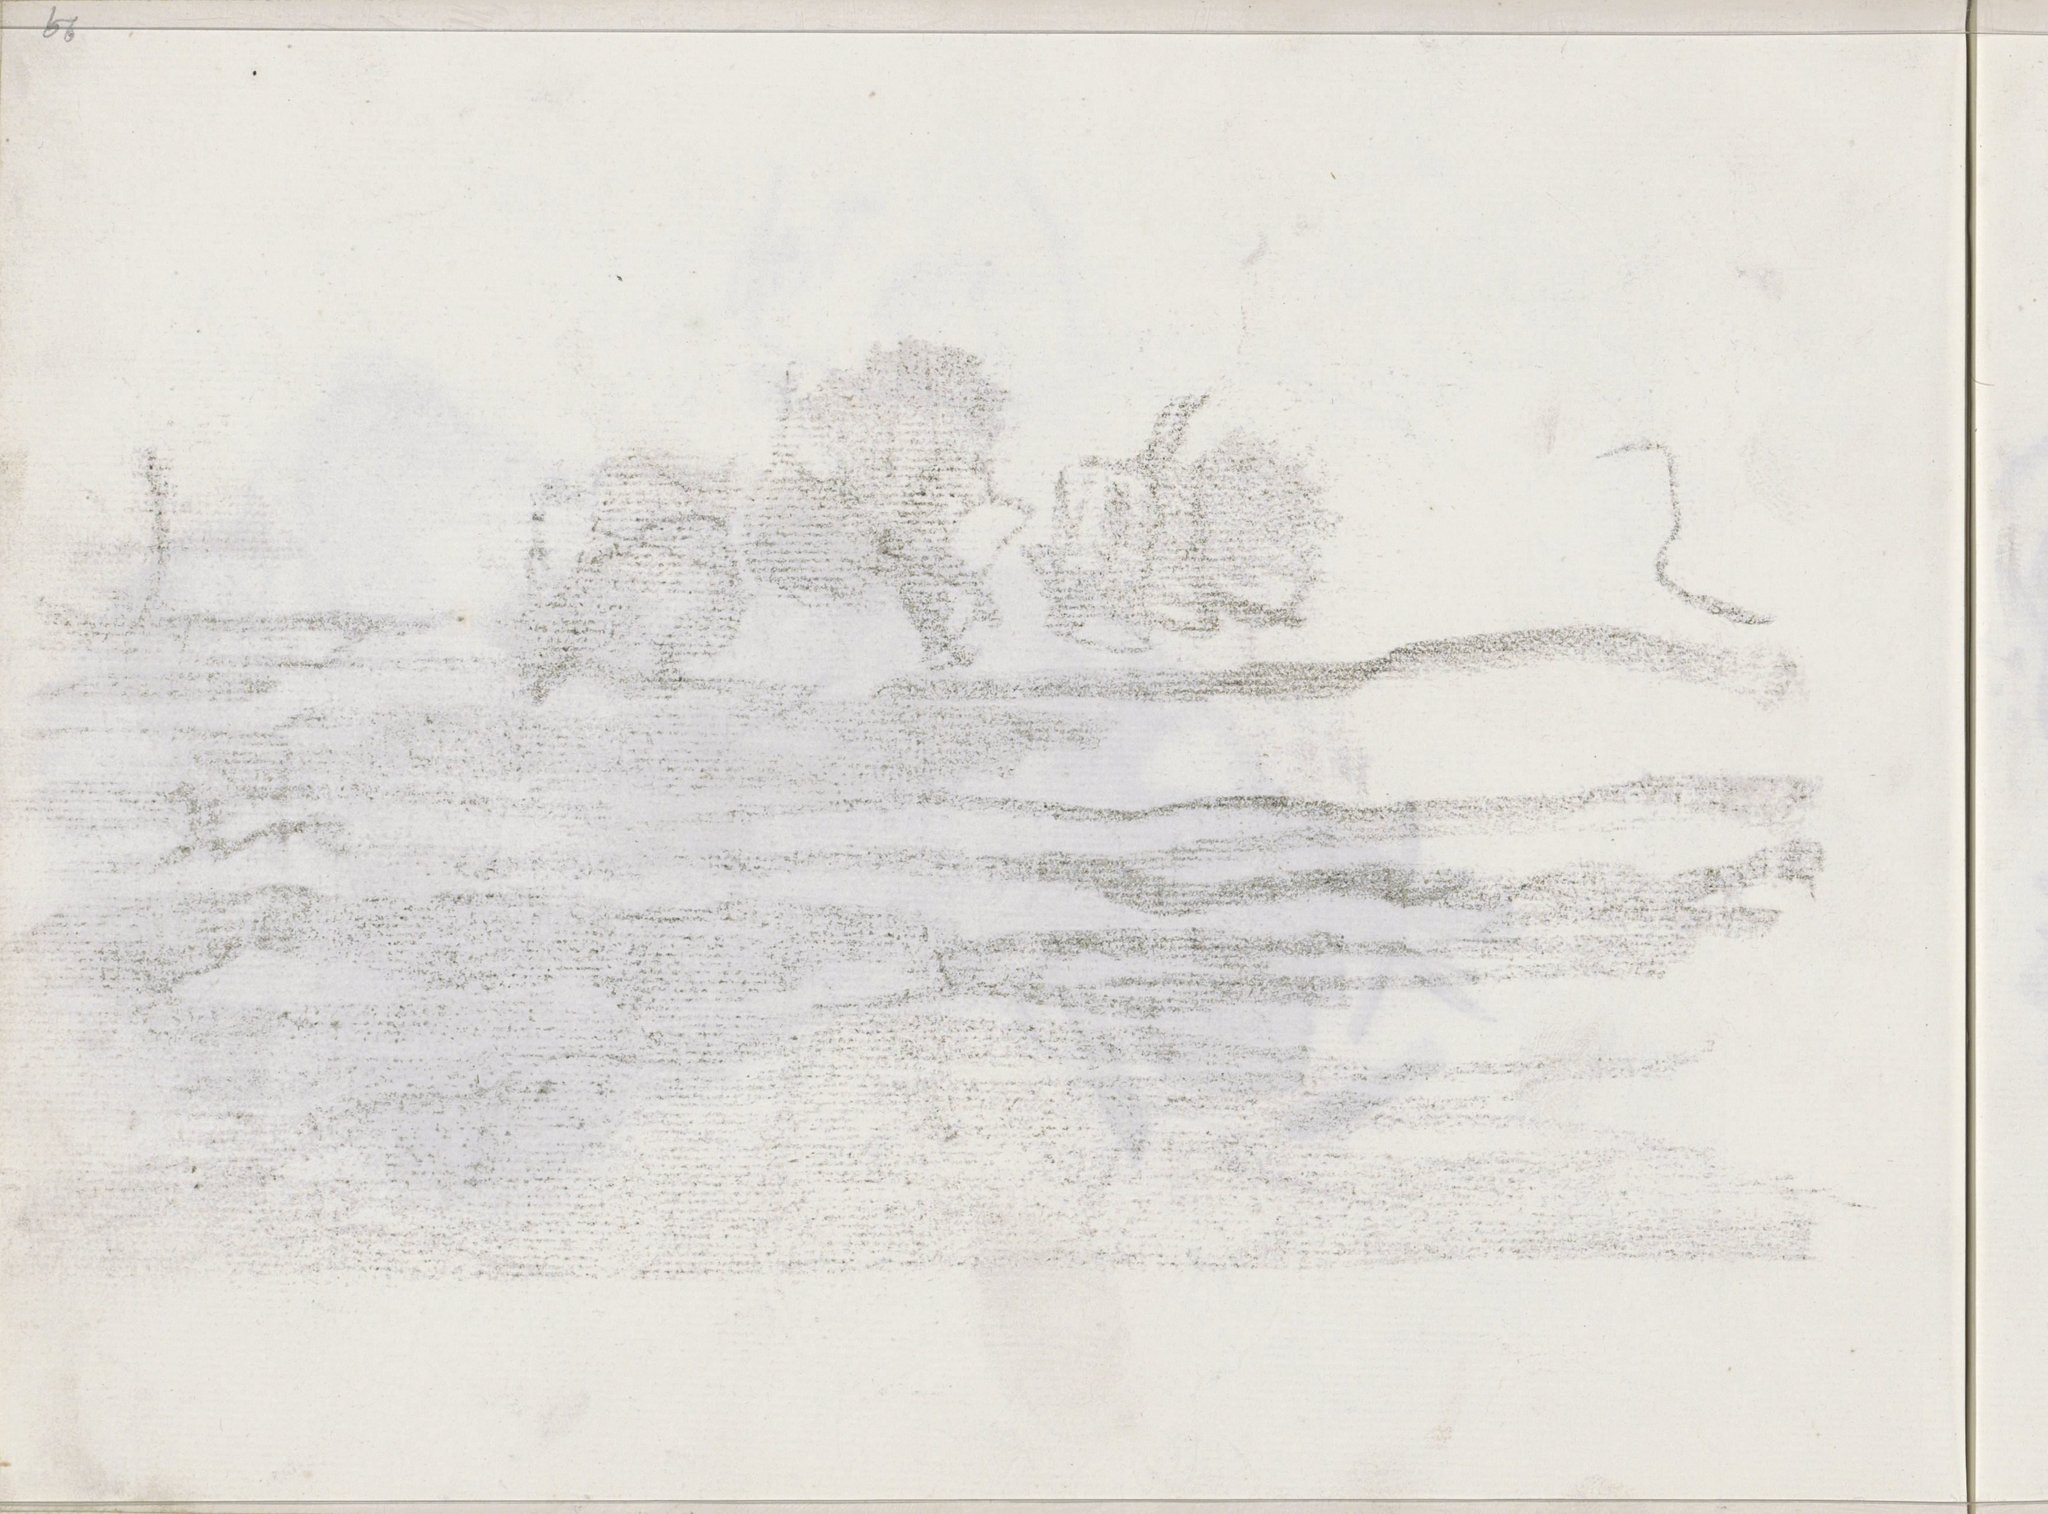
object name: sketchbook leaf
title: Abklatsch van de krijttekening op blad 11 recto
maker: isaac israels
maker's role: draughtsman, painter, print maker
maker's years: 1865-1934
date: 1875-1934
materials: paper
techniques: printmaking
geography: the hague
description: Blad 10 verso uit schetsboek XXI met 19 bladen.